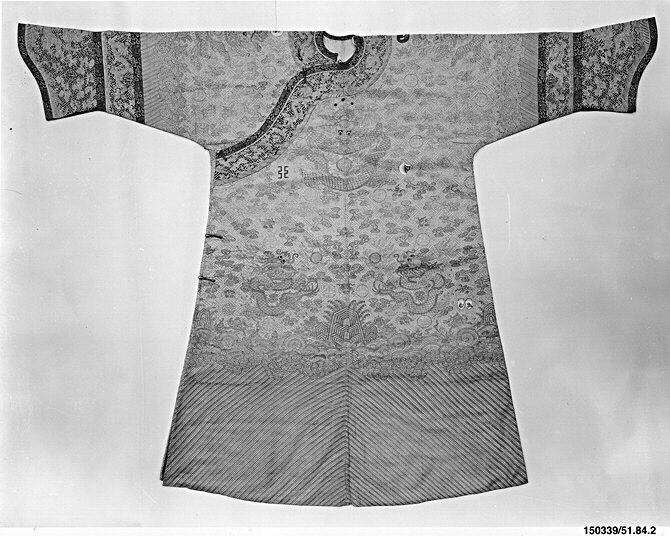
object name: robe, emperor's 12 symbol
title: Empress's Twelve-Symbol Robe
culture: chinese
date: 1867-1933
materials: silk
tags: dragons